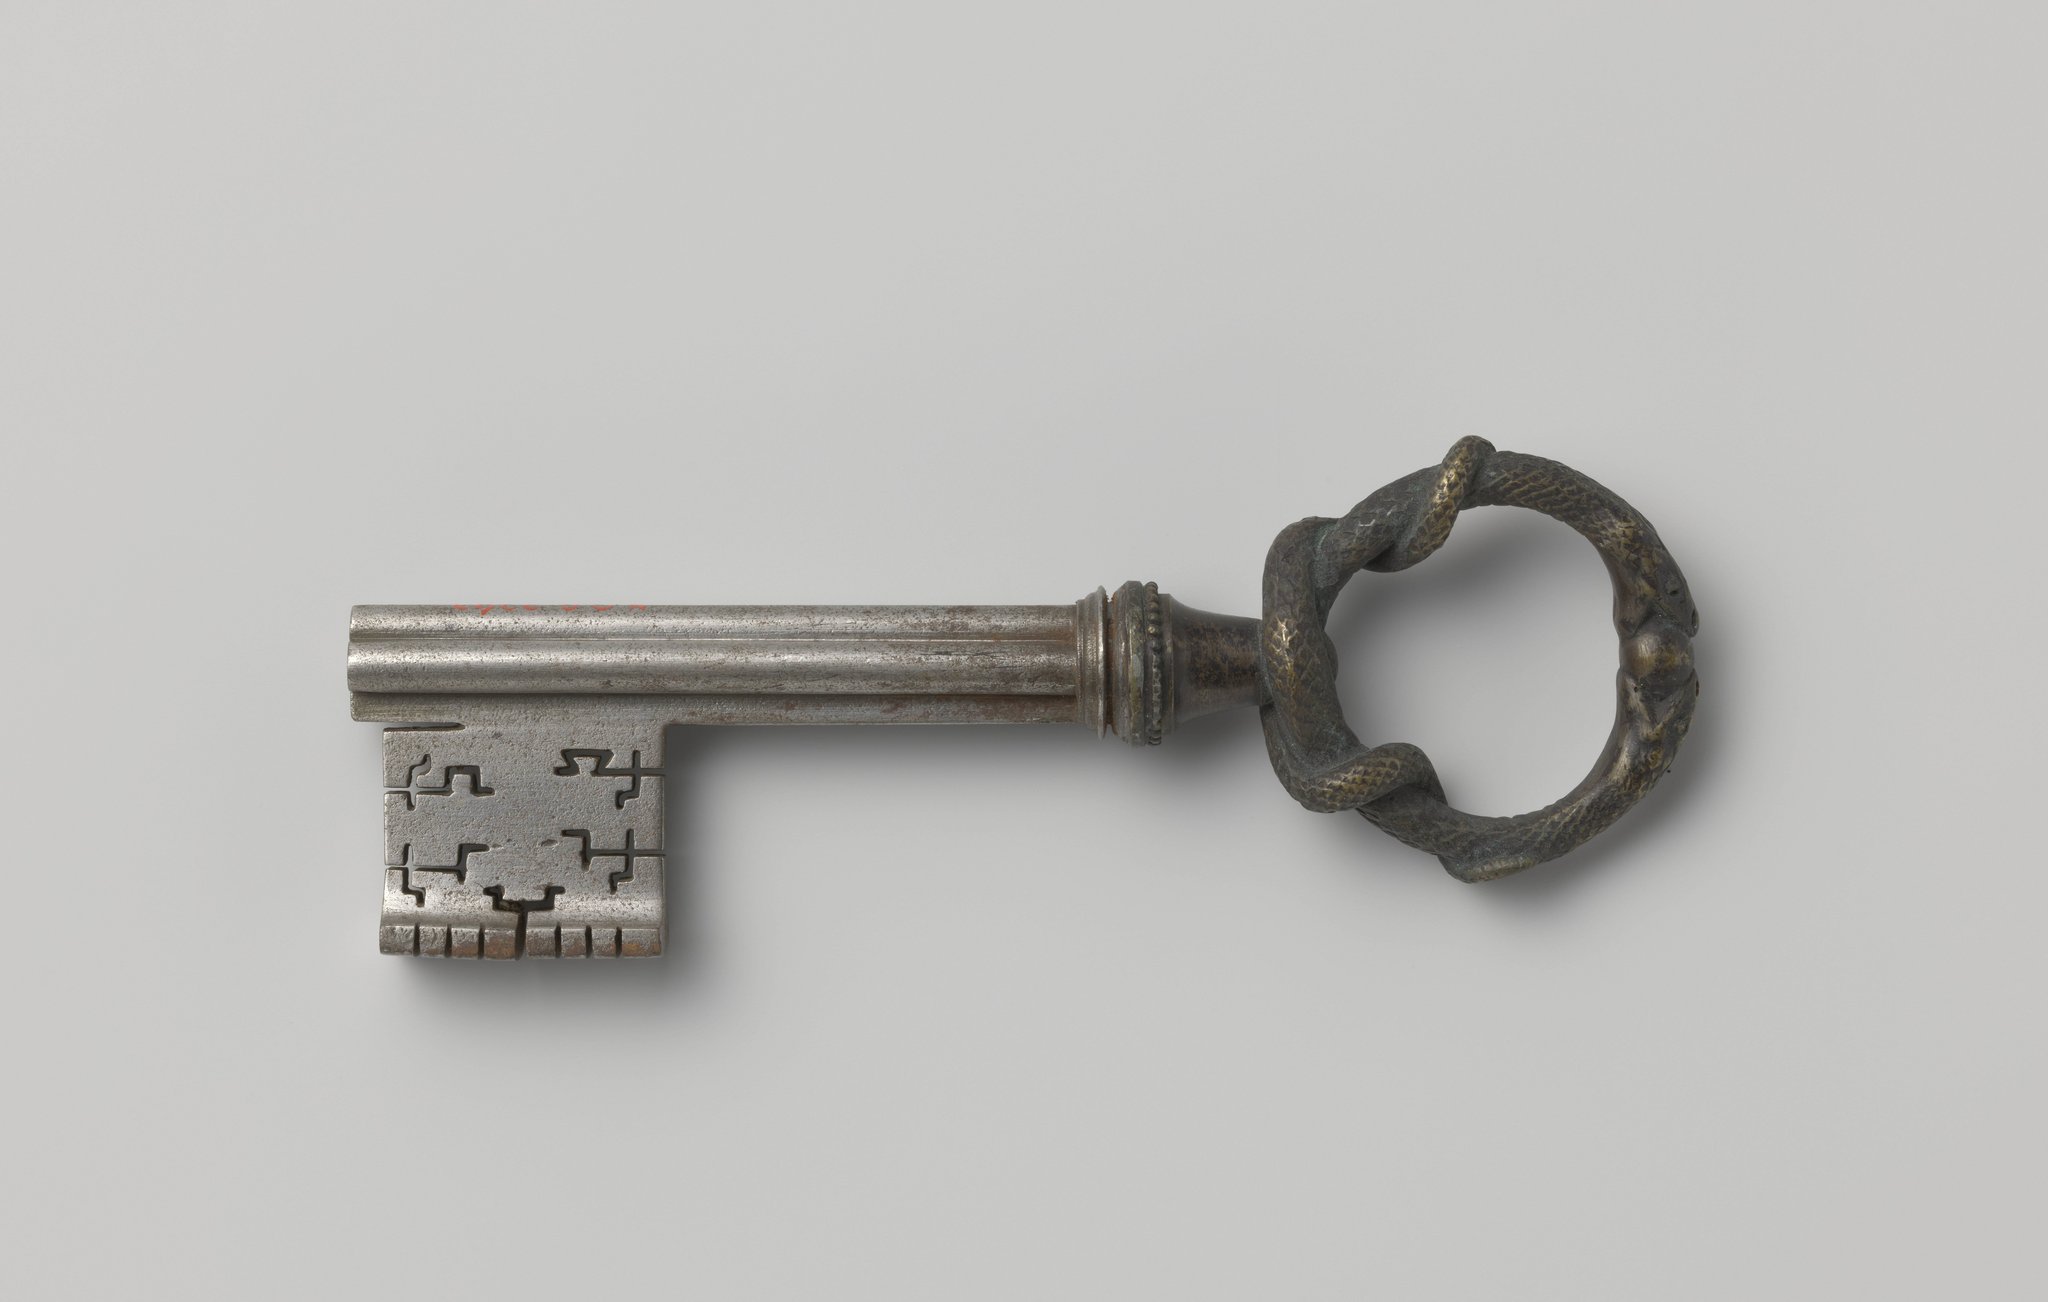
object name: key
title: Sleutel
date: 1400-1950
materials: bronze, iron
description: Geboorde sleutel met klaverbladvormige schacht. Het ronde oog bestaat uit twee van elkaar heen kronkelende slangen, die in de toegewende koppen een bal in de bek houden. Zij omklemmen onderaan een Tonische verhoging van het ronde, met parelsnoer versierde kapiteel. Hieronder schijfvormige sleutelborst aangebracht. Oog en kapiteel van brons, sleutelborst, schacht en baard van ijzer.